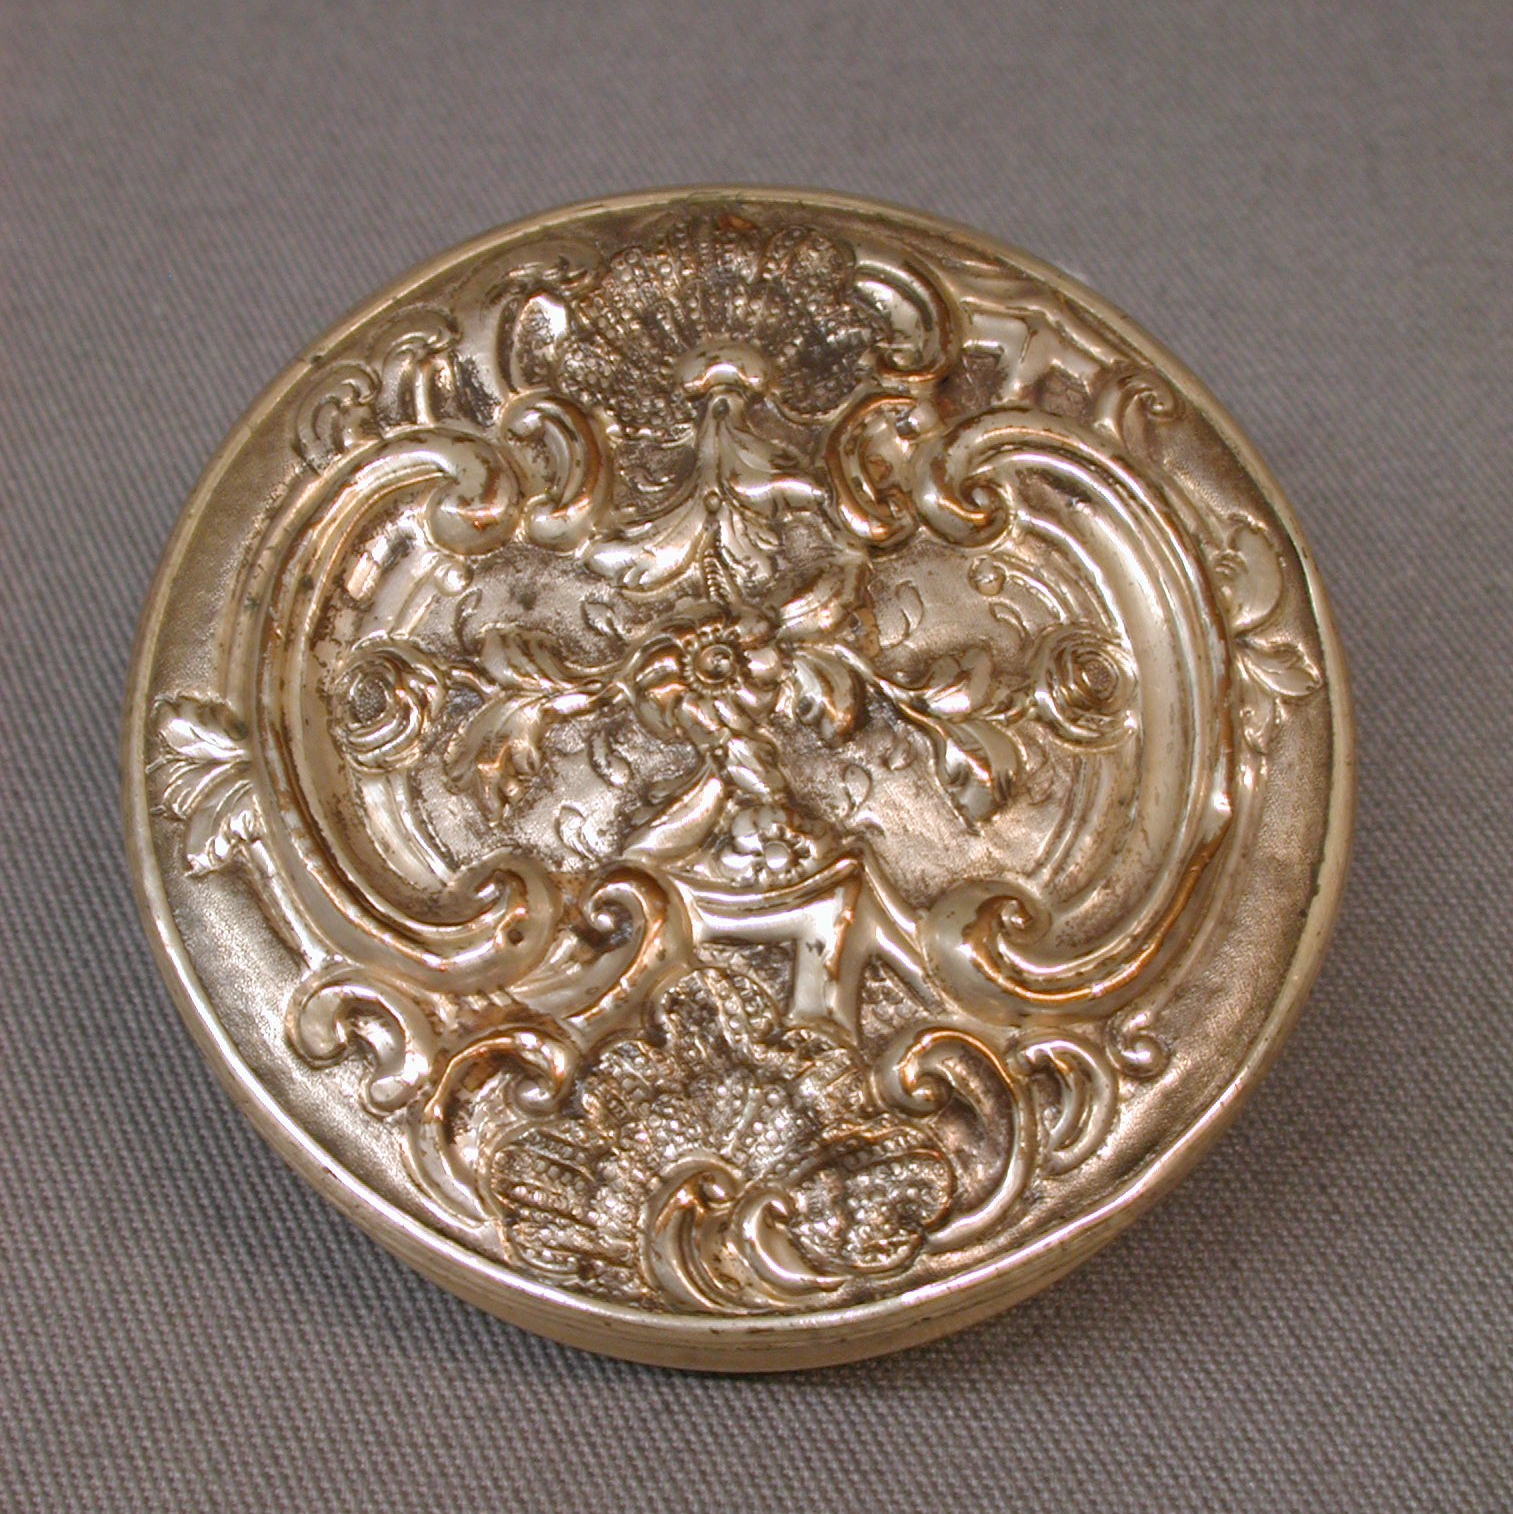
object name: snuffbox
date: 1750-1760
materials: metal